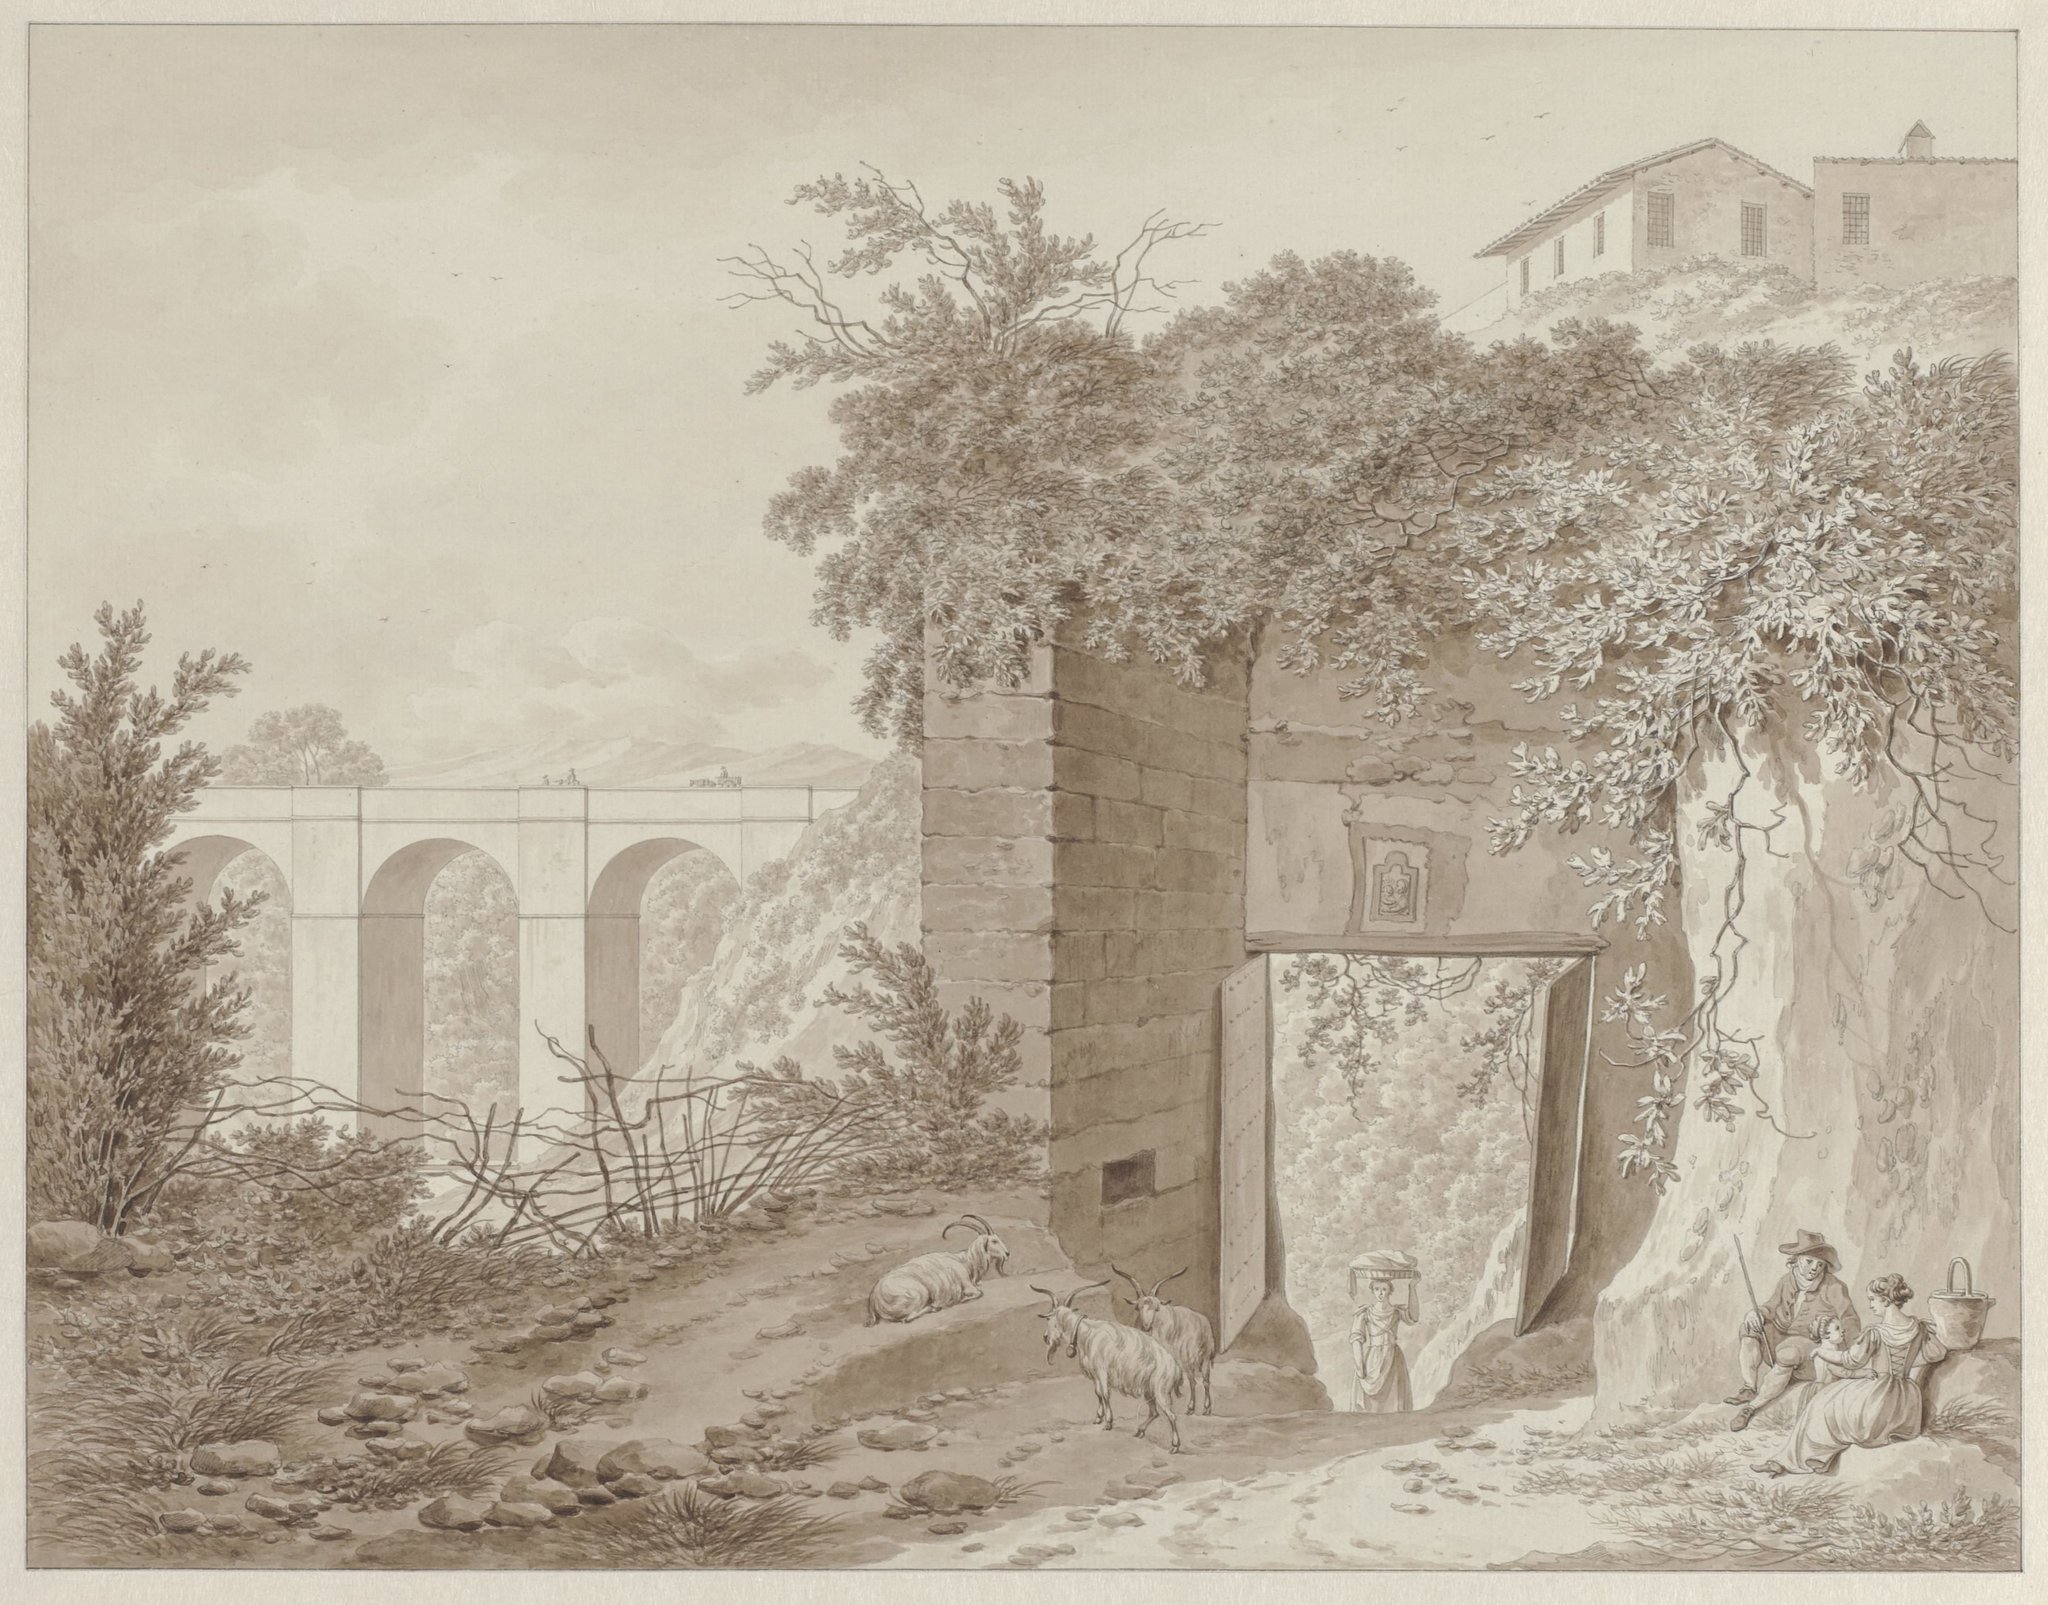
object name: drawing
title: Bij Civita Castellana, rechts op de voorgrond een rustend gezin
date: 1792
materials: chalk, ink, paper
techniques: brush, pen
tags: landscape with bridge, viaduct or aqueduct, landscape with ruins, city-gate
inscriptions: date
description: Tekening uit een groep tekeningen van landschappen en stadsgezichten in Italië (Rome, Tivoli, Civita Castellana en Pozzuoli).